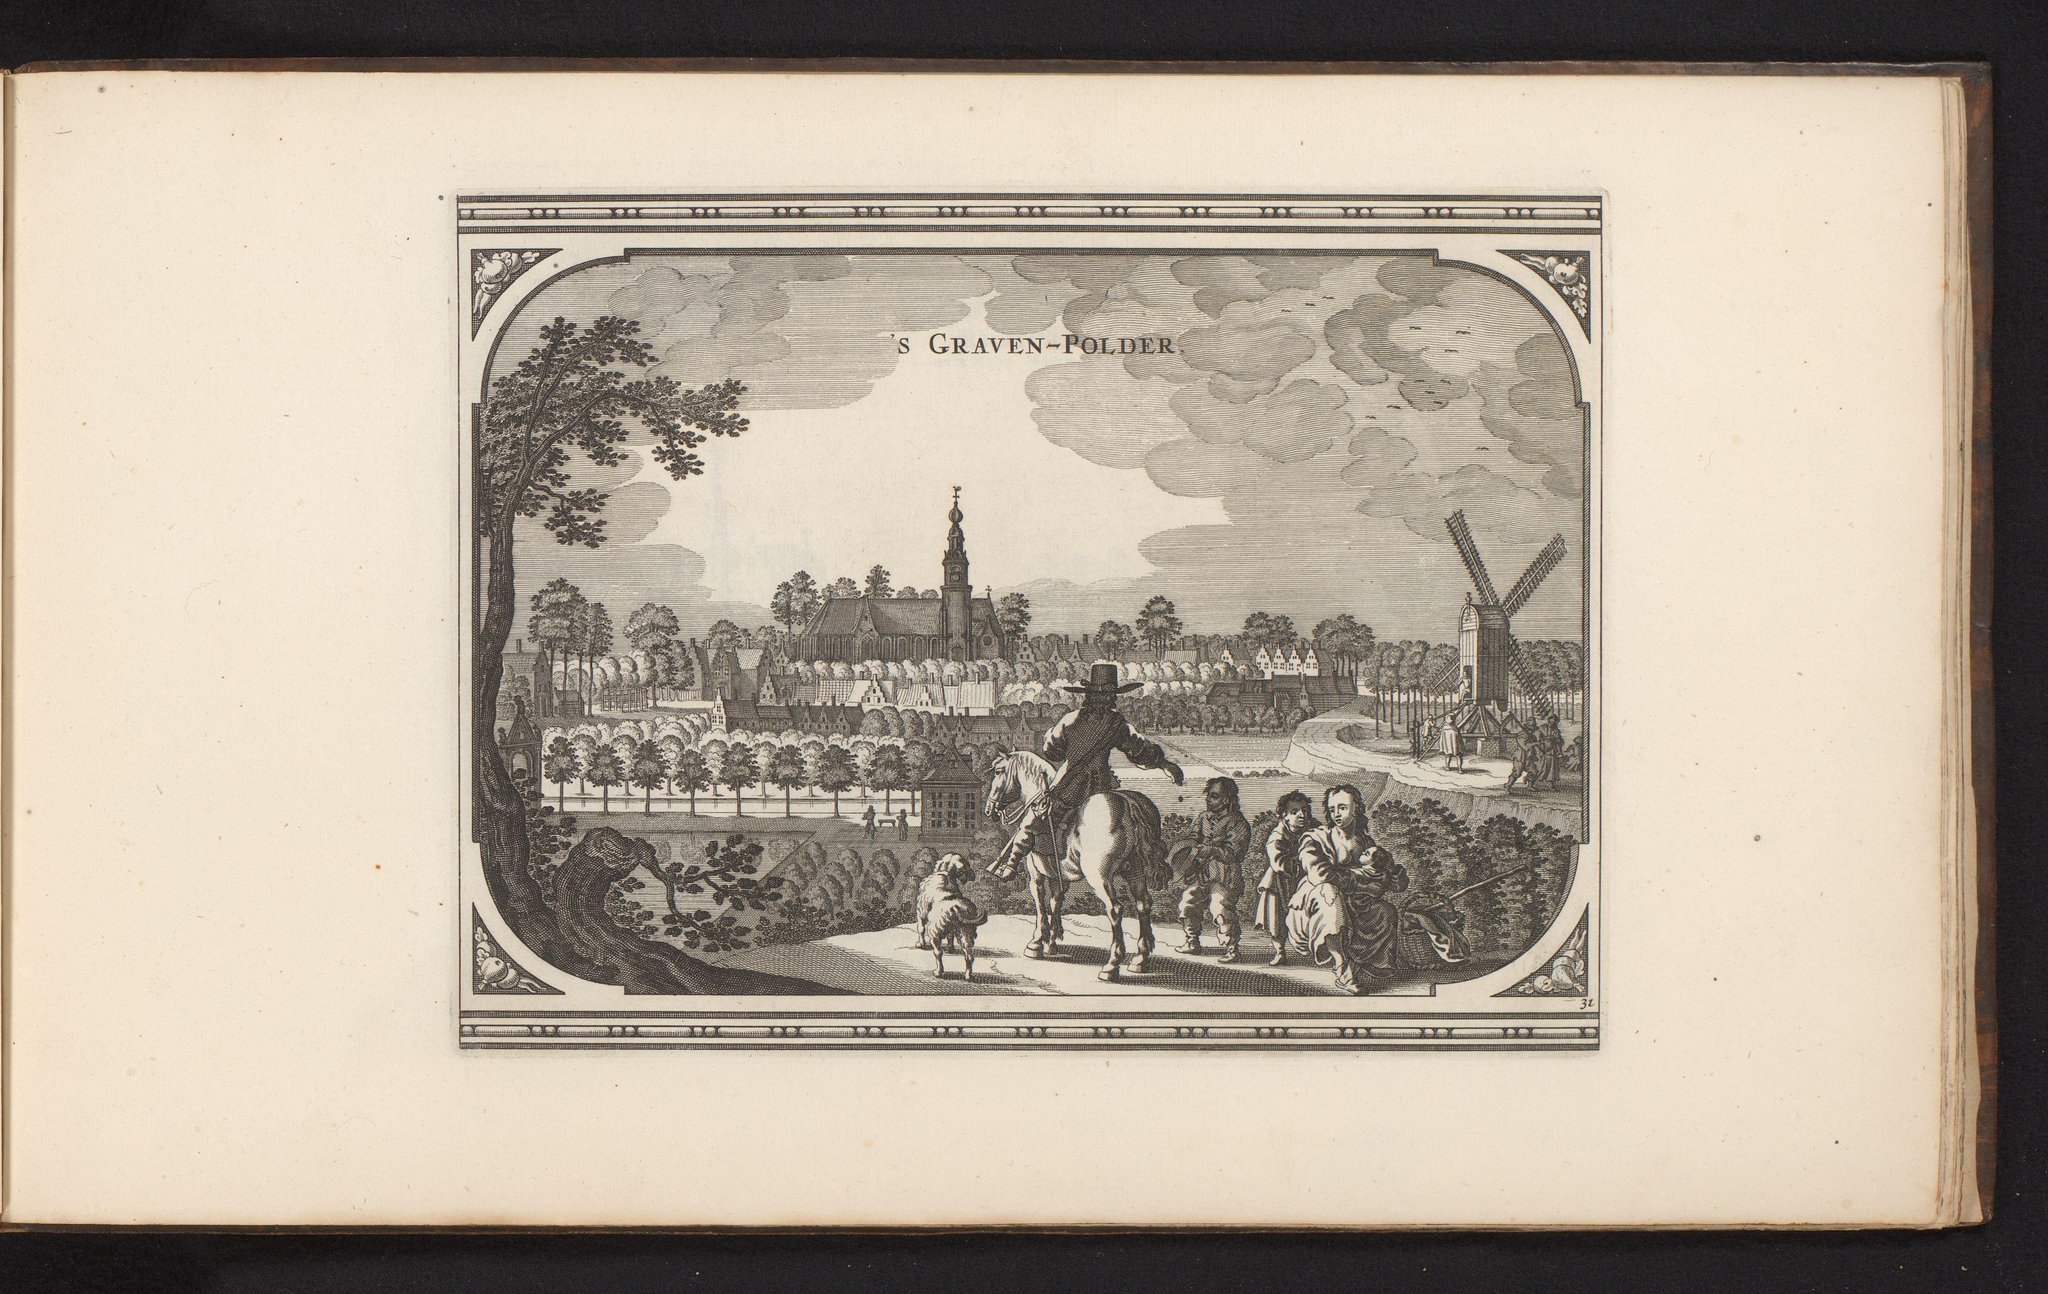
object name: album leaf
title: Gezicht op 's-Gravenpolder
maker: pieter hendricksz. schut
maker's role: print maker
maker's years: 1618-1660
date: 1662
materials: paper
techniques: etching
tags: city-view, and landscape with man-made constructions, the rich, factories and mills in landscape, giving alms; collection, the poor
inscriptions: collector's mark: Lugt 195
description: Gezicht op 's-Gravenpolder met kerk en molen. Op de voorgrond geeft een welgestelde heer te paard een aalmoes aan een arme jongen en zijn moeder. De prent maakt deel uit van een album.